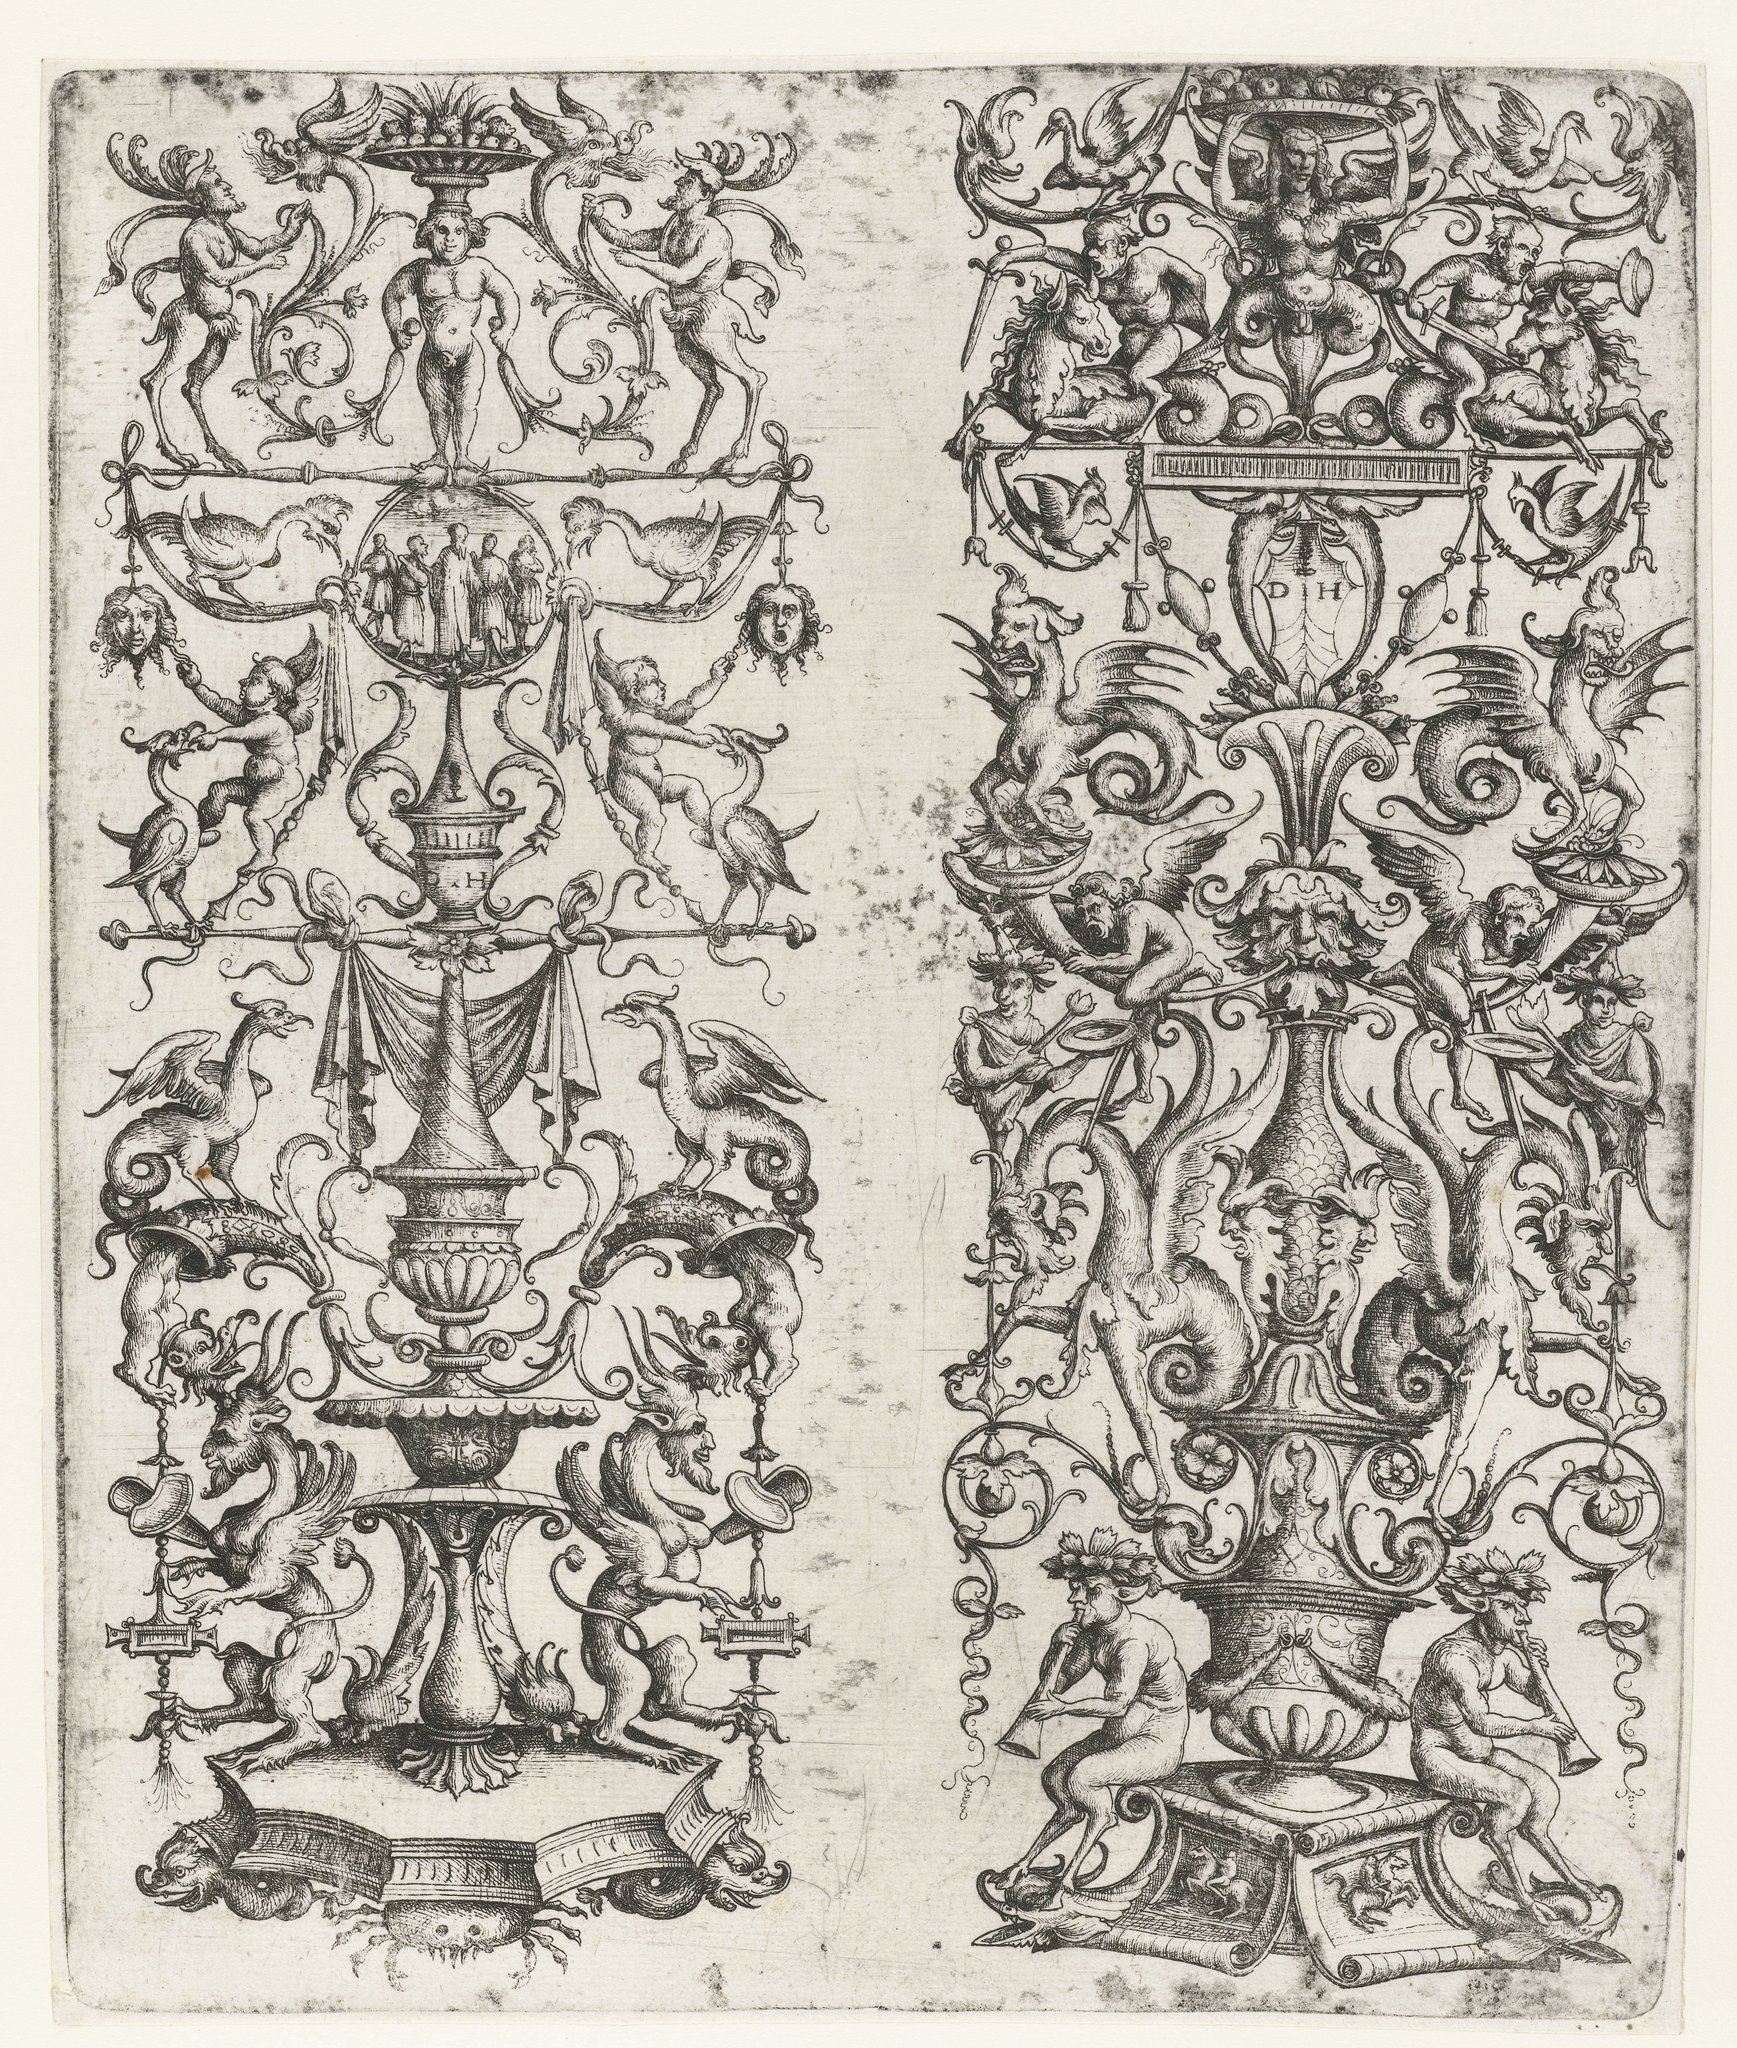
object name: print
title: Kandelabers met grotesken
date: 1480-1536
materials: paper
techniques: etching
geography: germany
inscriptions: collector's mark: Lugt 240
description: Vlakdecoratie. Twee ontwerpen op een blad. Aan de voet van de linker kandelaber zitten twee griffioenachtige wezens met saterkoppen, aan de voet van de rechter twee saters die op schalmeien blazen.